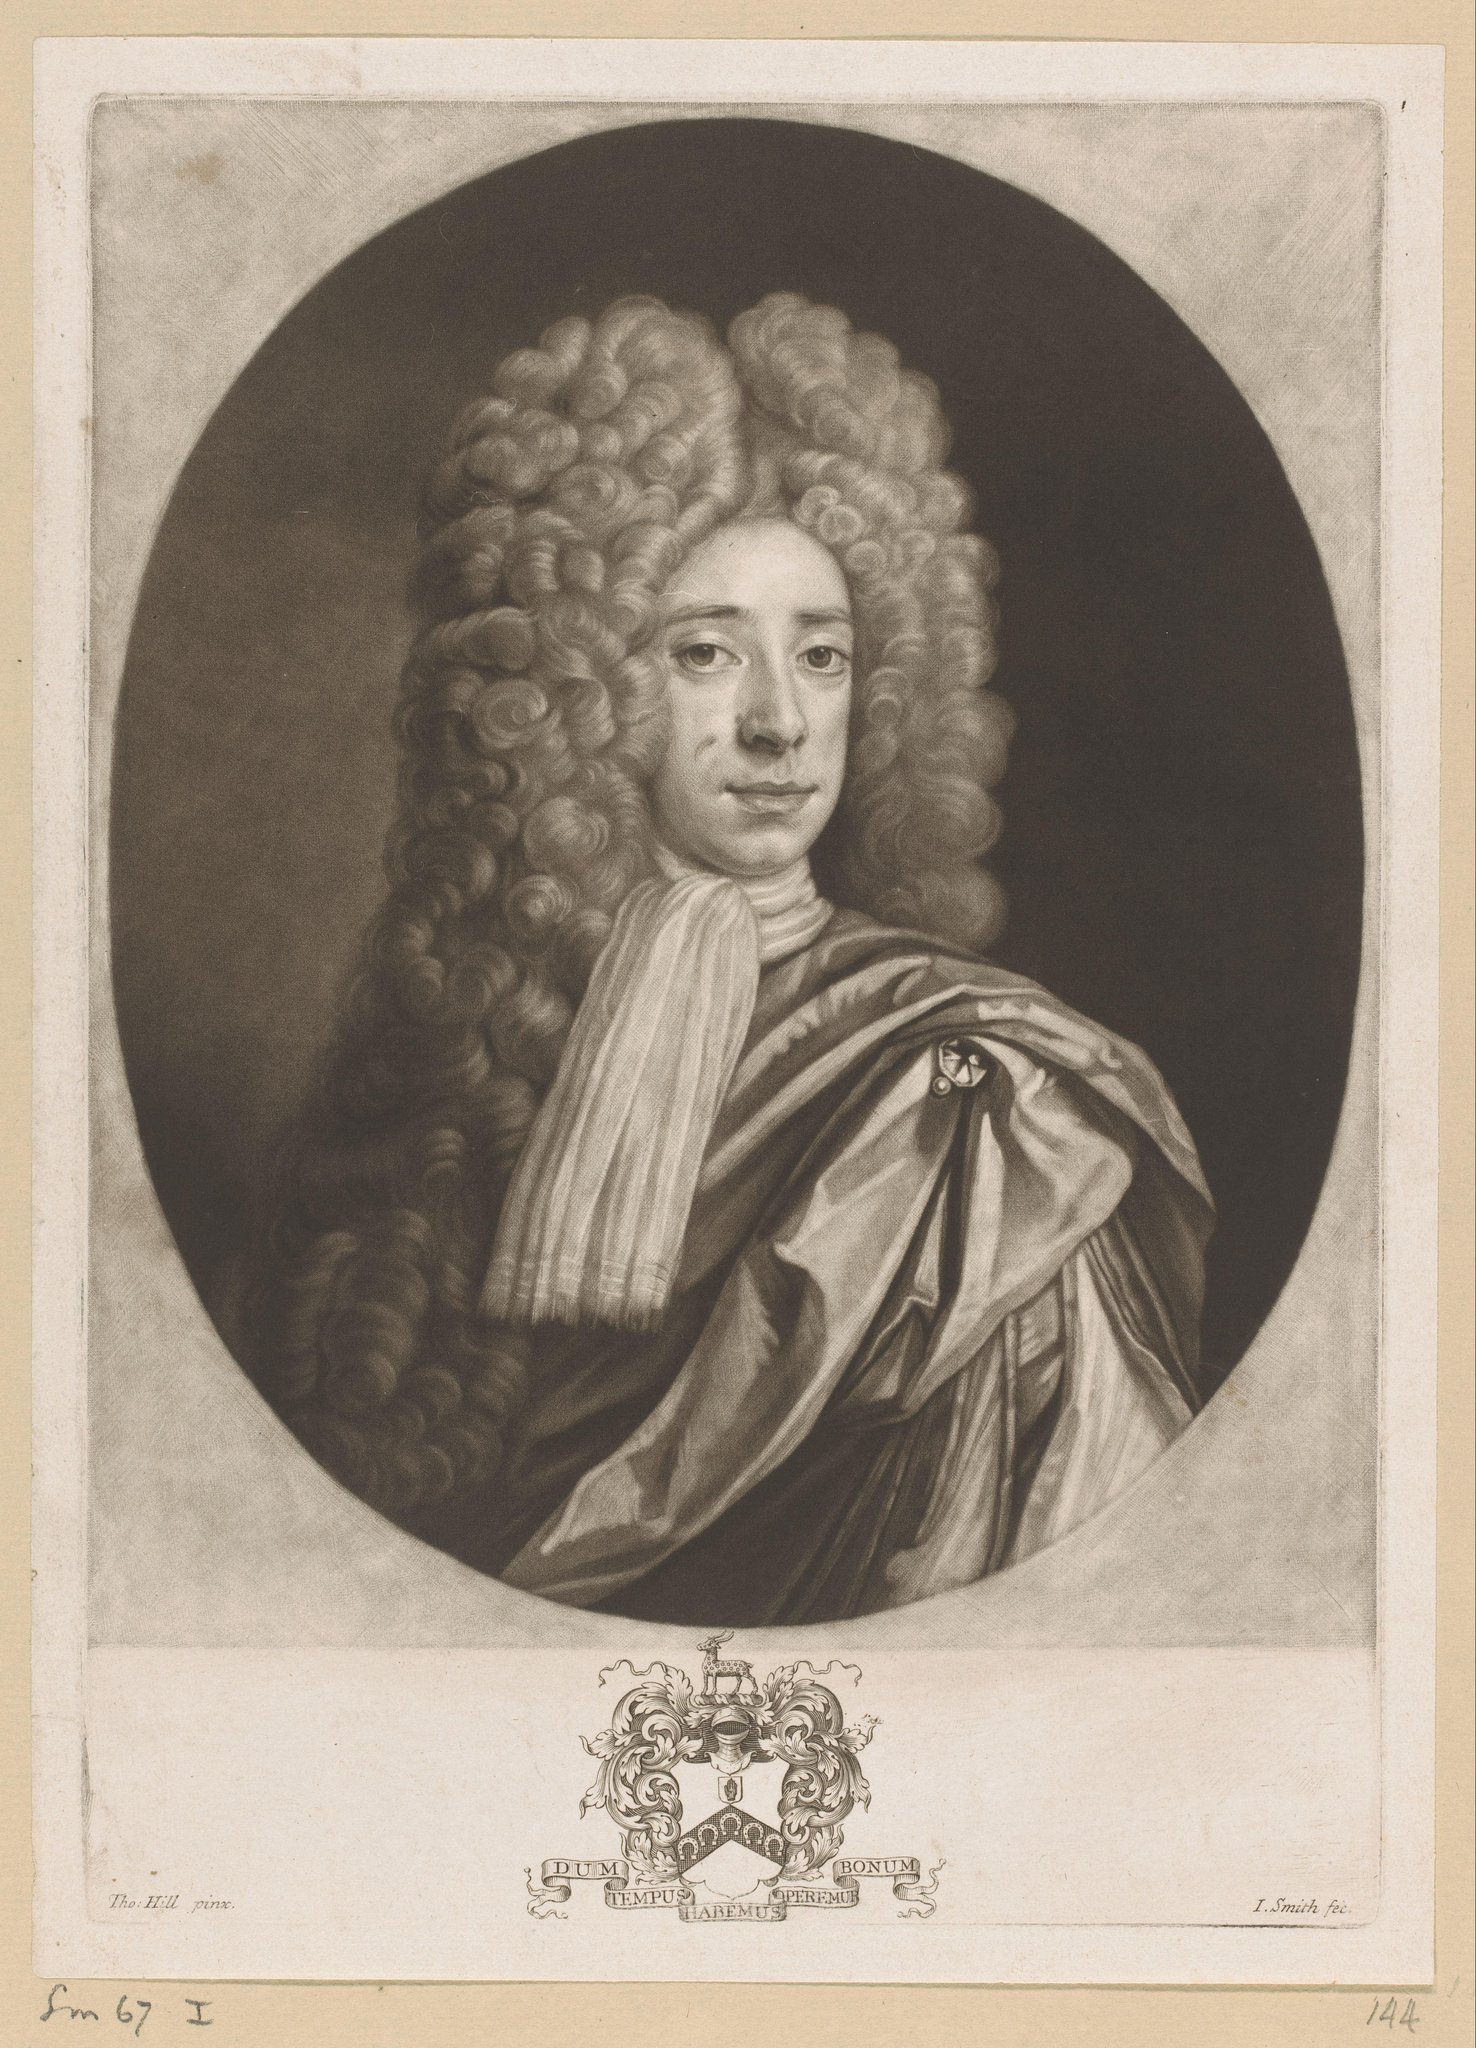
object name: print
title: Portret van John Crispe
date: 1683-1742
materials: paper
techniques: mezzotint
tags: historical persons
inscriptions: collector's mark: Lugt 240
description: Tekst in het Latijn in de banier in de ondermarge.